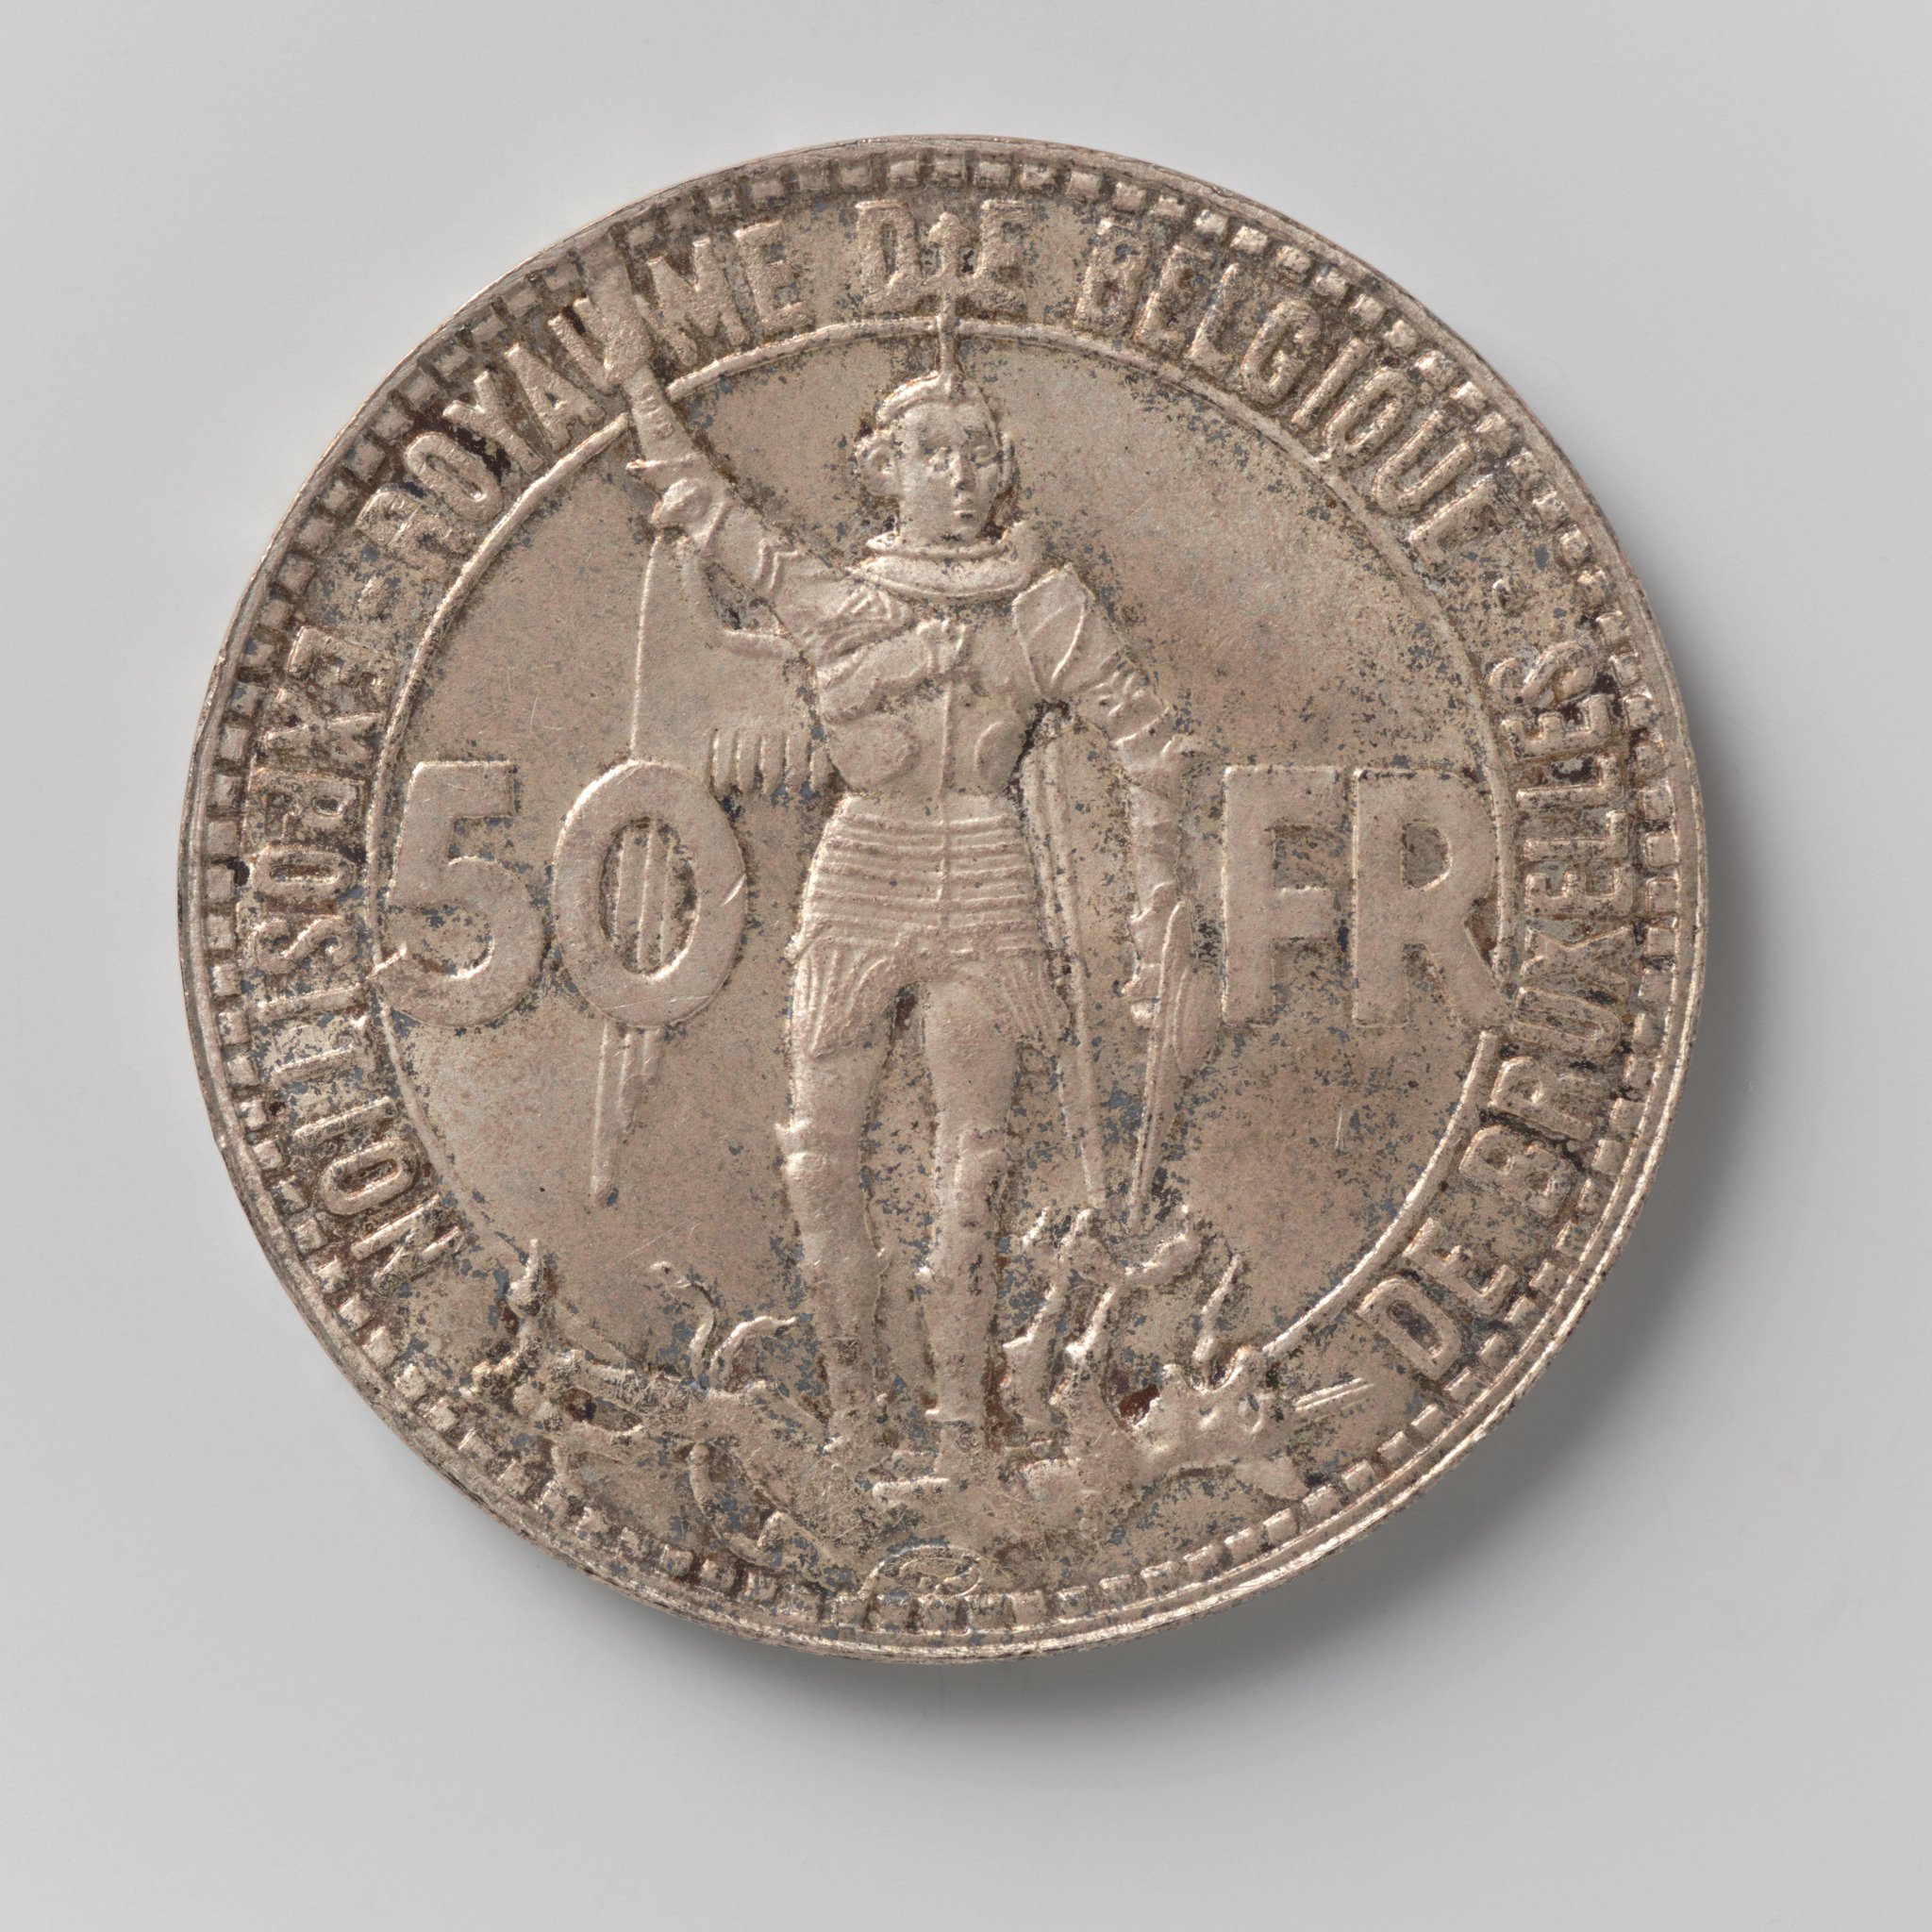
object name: coin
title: 50 francs uit België van Leopold III, 1935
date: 1935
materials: silver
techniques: striking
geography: brussels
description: Zilveren munt. Voorzijde: tussen waarde-aanduiding op monster staande geharnaste man. Keerzijde: stationsgebouw. Daarboven jaartallen 1835 en 1935. Randschrift.